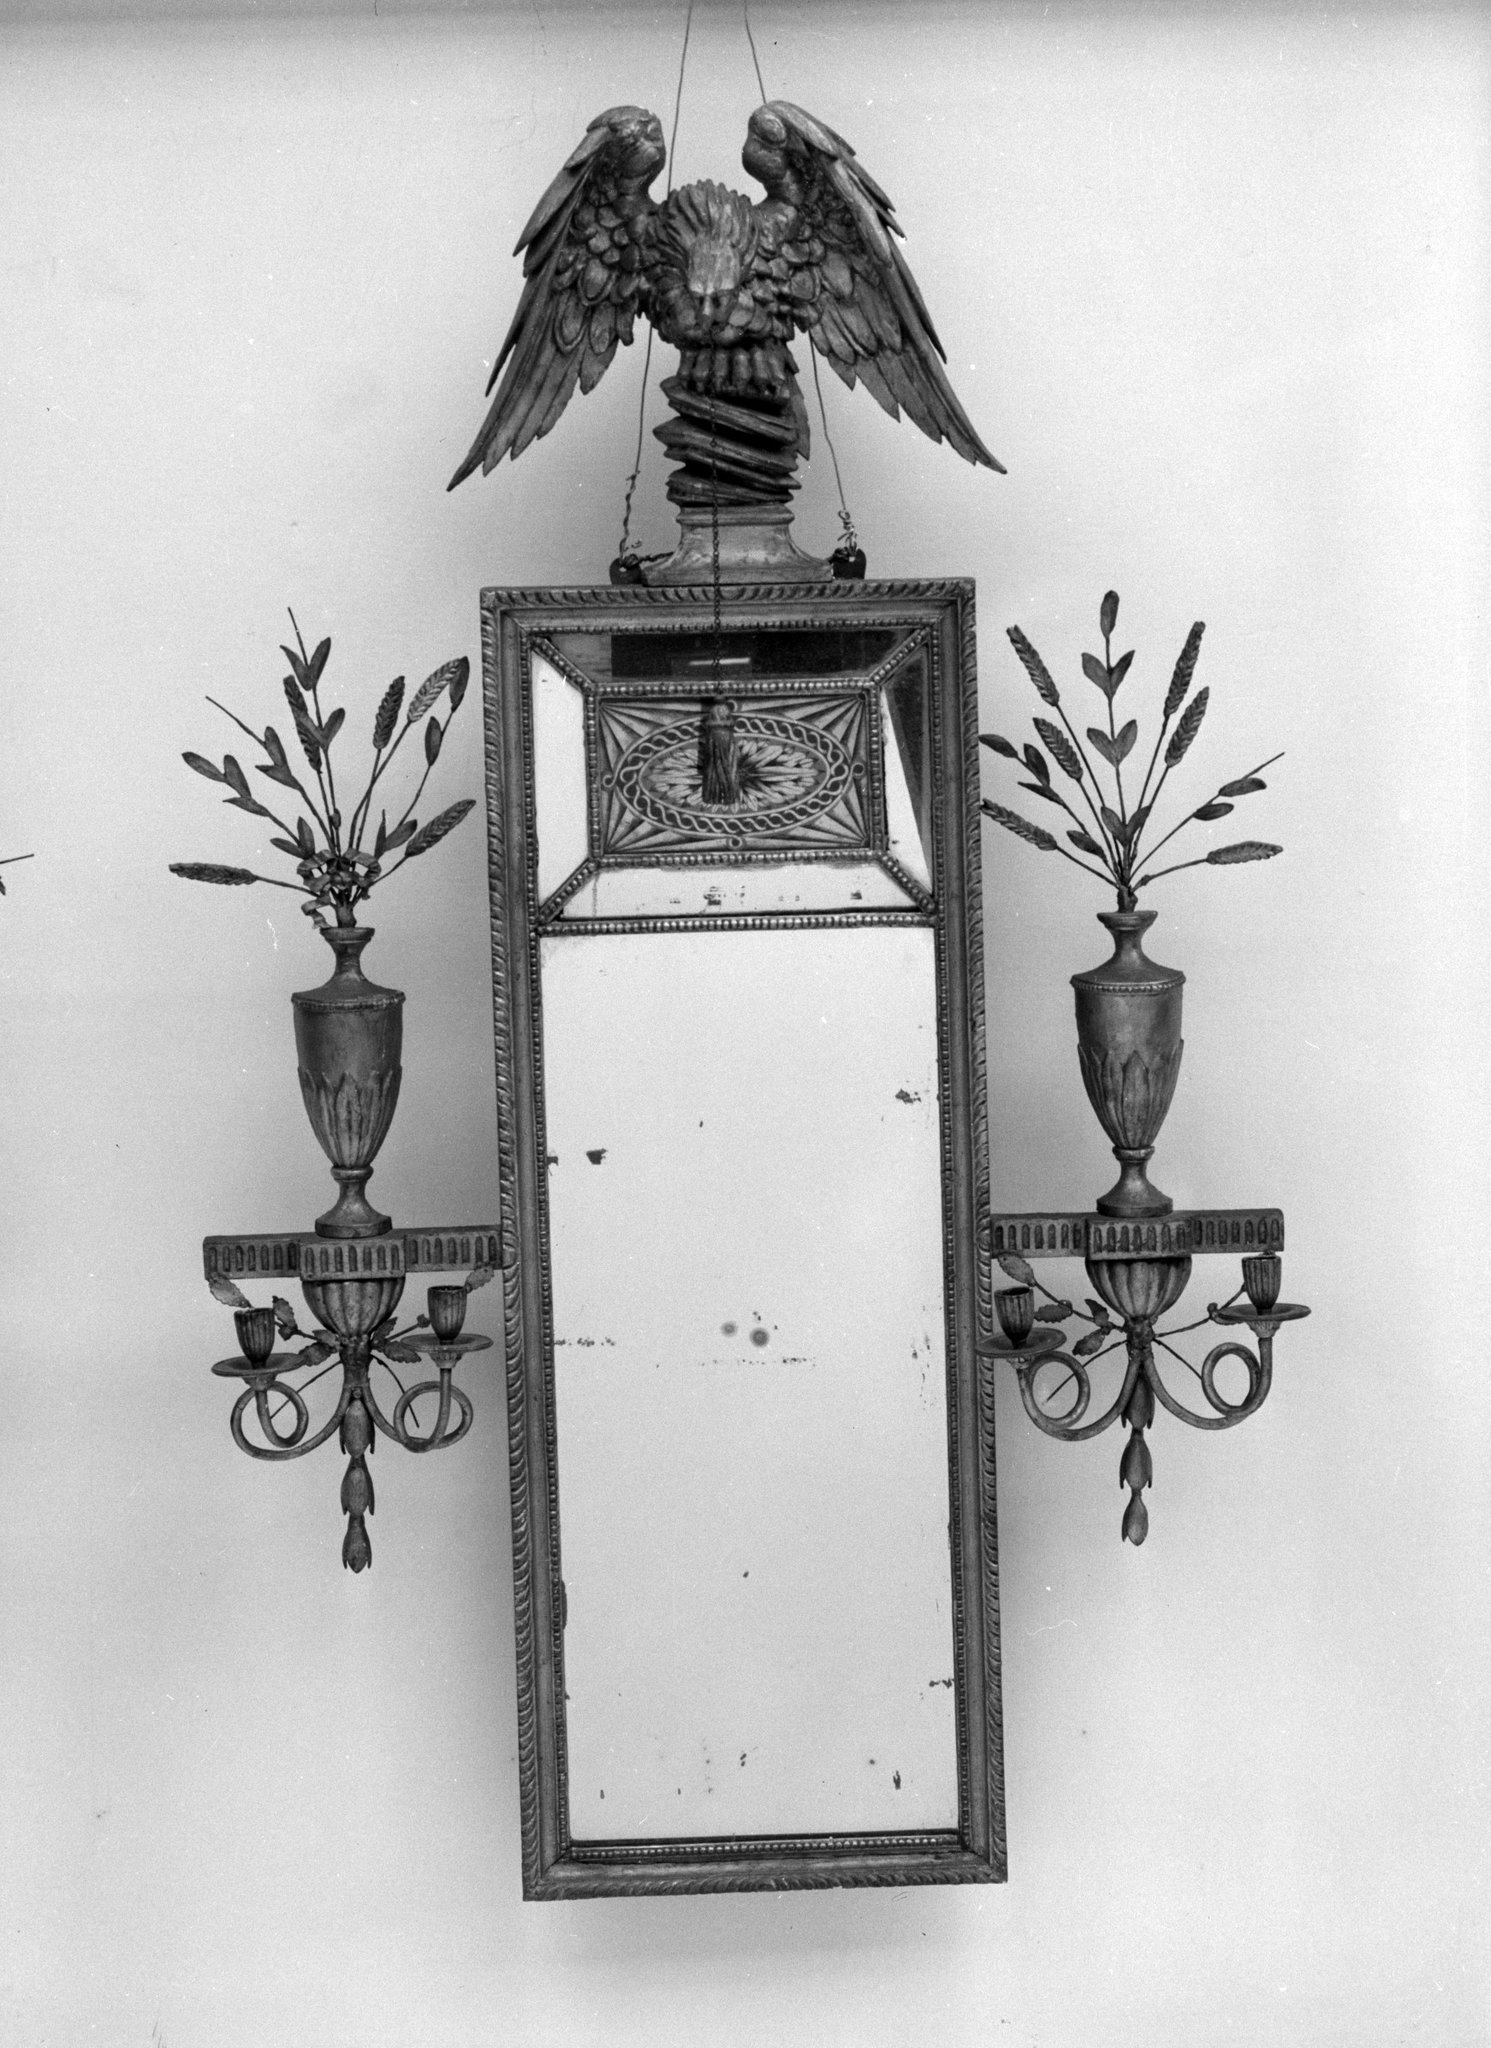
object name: looking glass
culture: american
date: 1795-1810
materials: gesso, wood, metal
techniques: gilding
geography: united states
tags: eagles